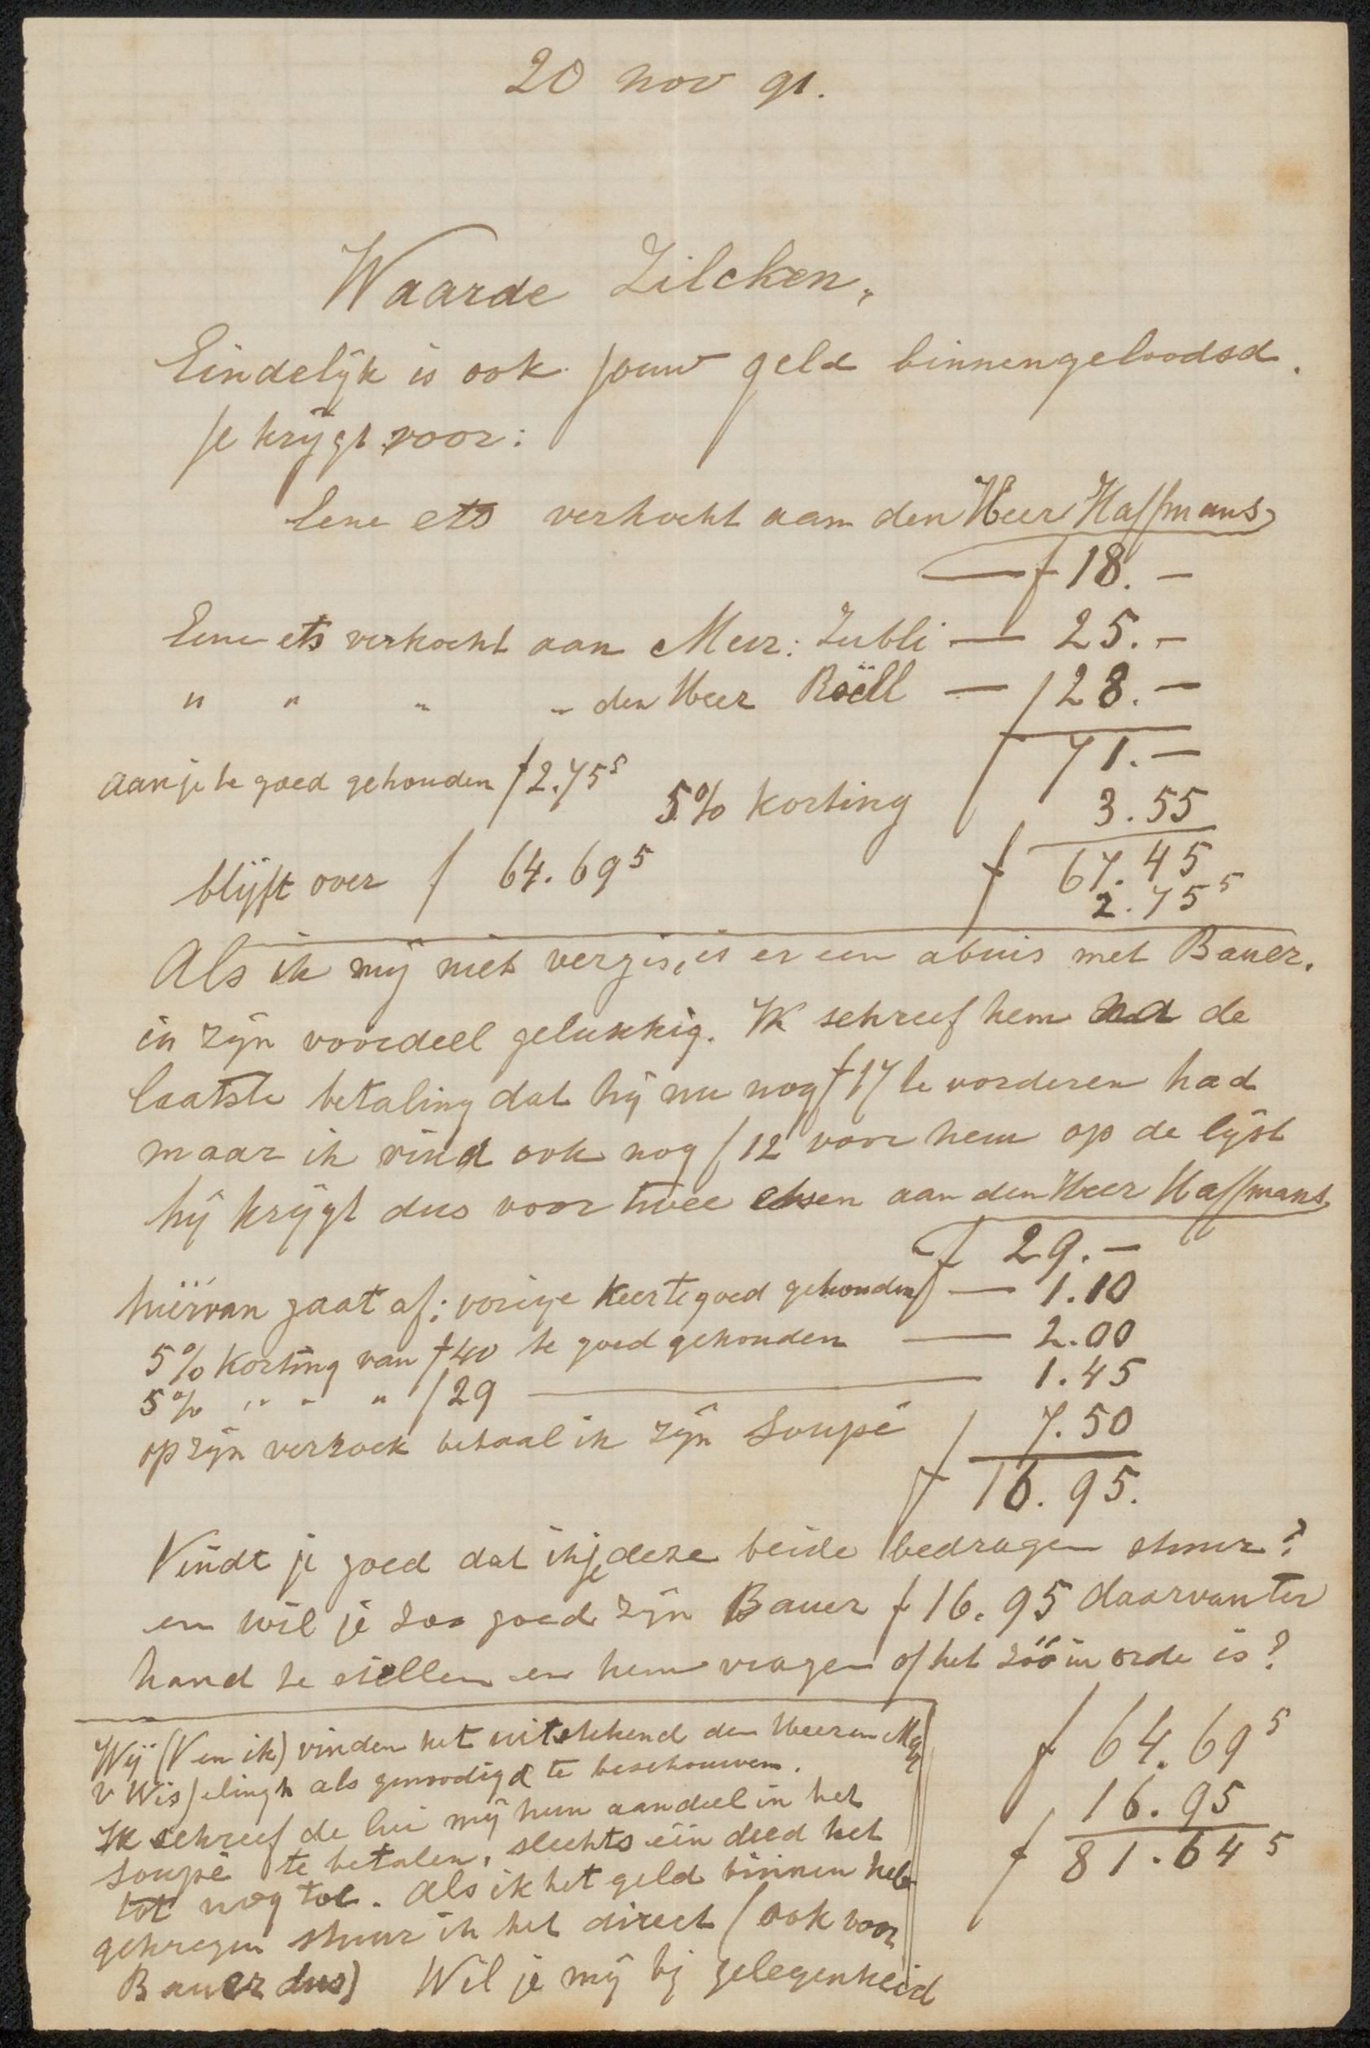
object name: letter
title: Brief aan Philip Zilcken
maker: eduard karsen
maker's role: draughtsman, painter, print maker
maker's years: 1860-1941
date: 1891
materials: ink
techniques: pen, writing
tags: dordrecht, amsterdam, painter, print maker, draughtsman, designer, jan veth, marius bauer, elbert jan van wisselingh, the hague, philip zilcken, exhibition ~ art, money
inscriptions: collector's mark: ‘RPK’